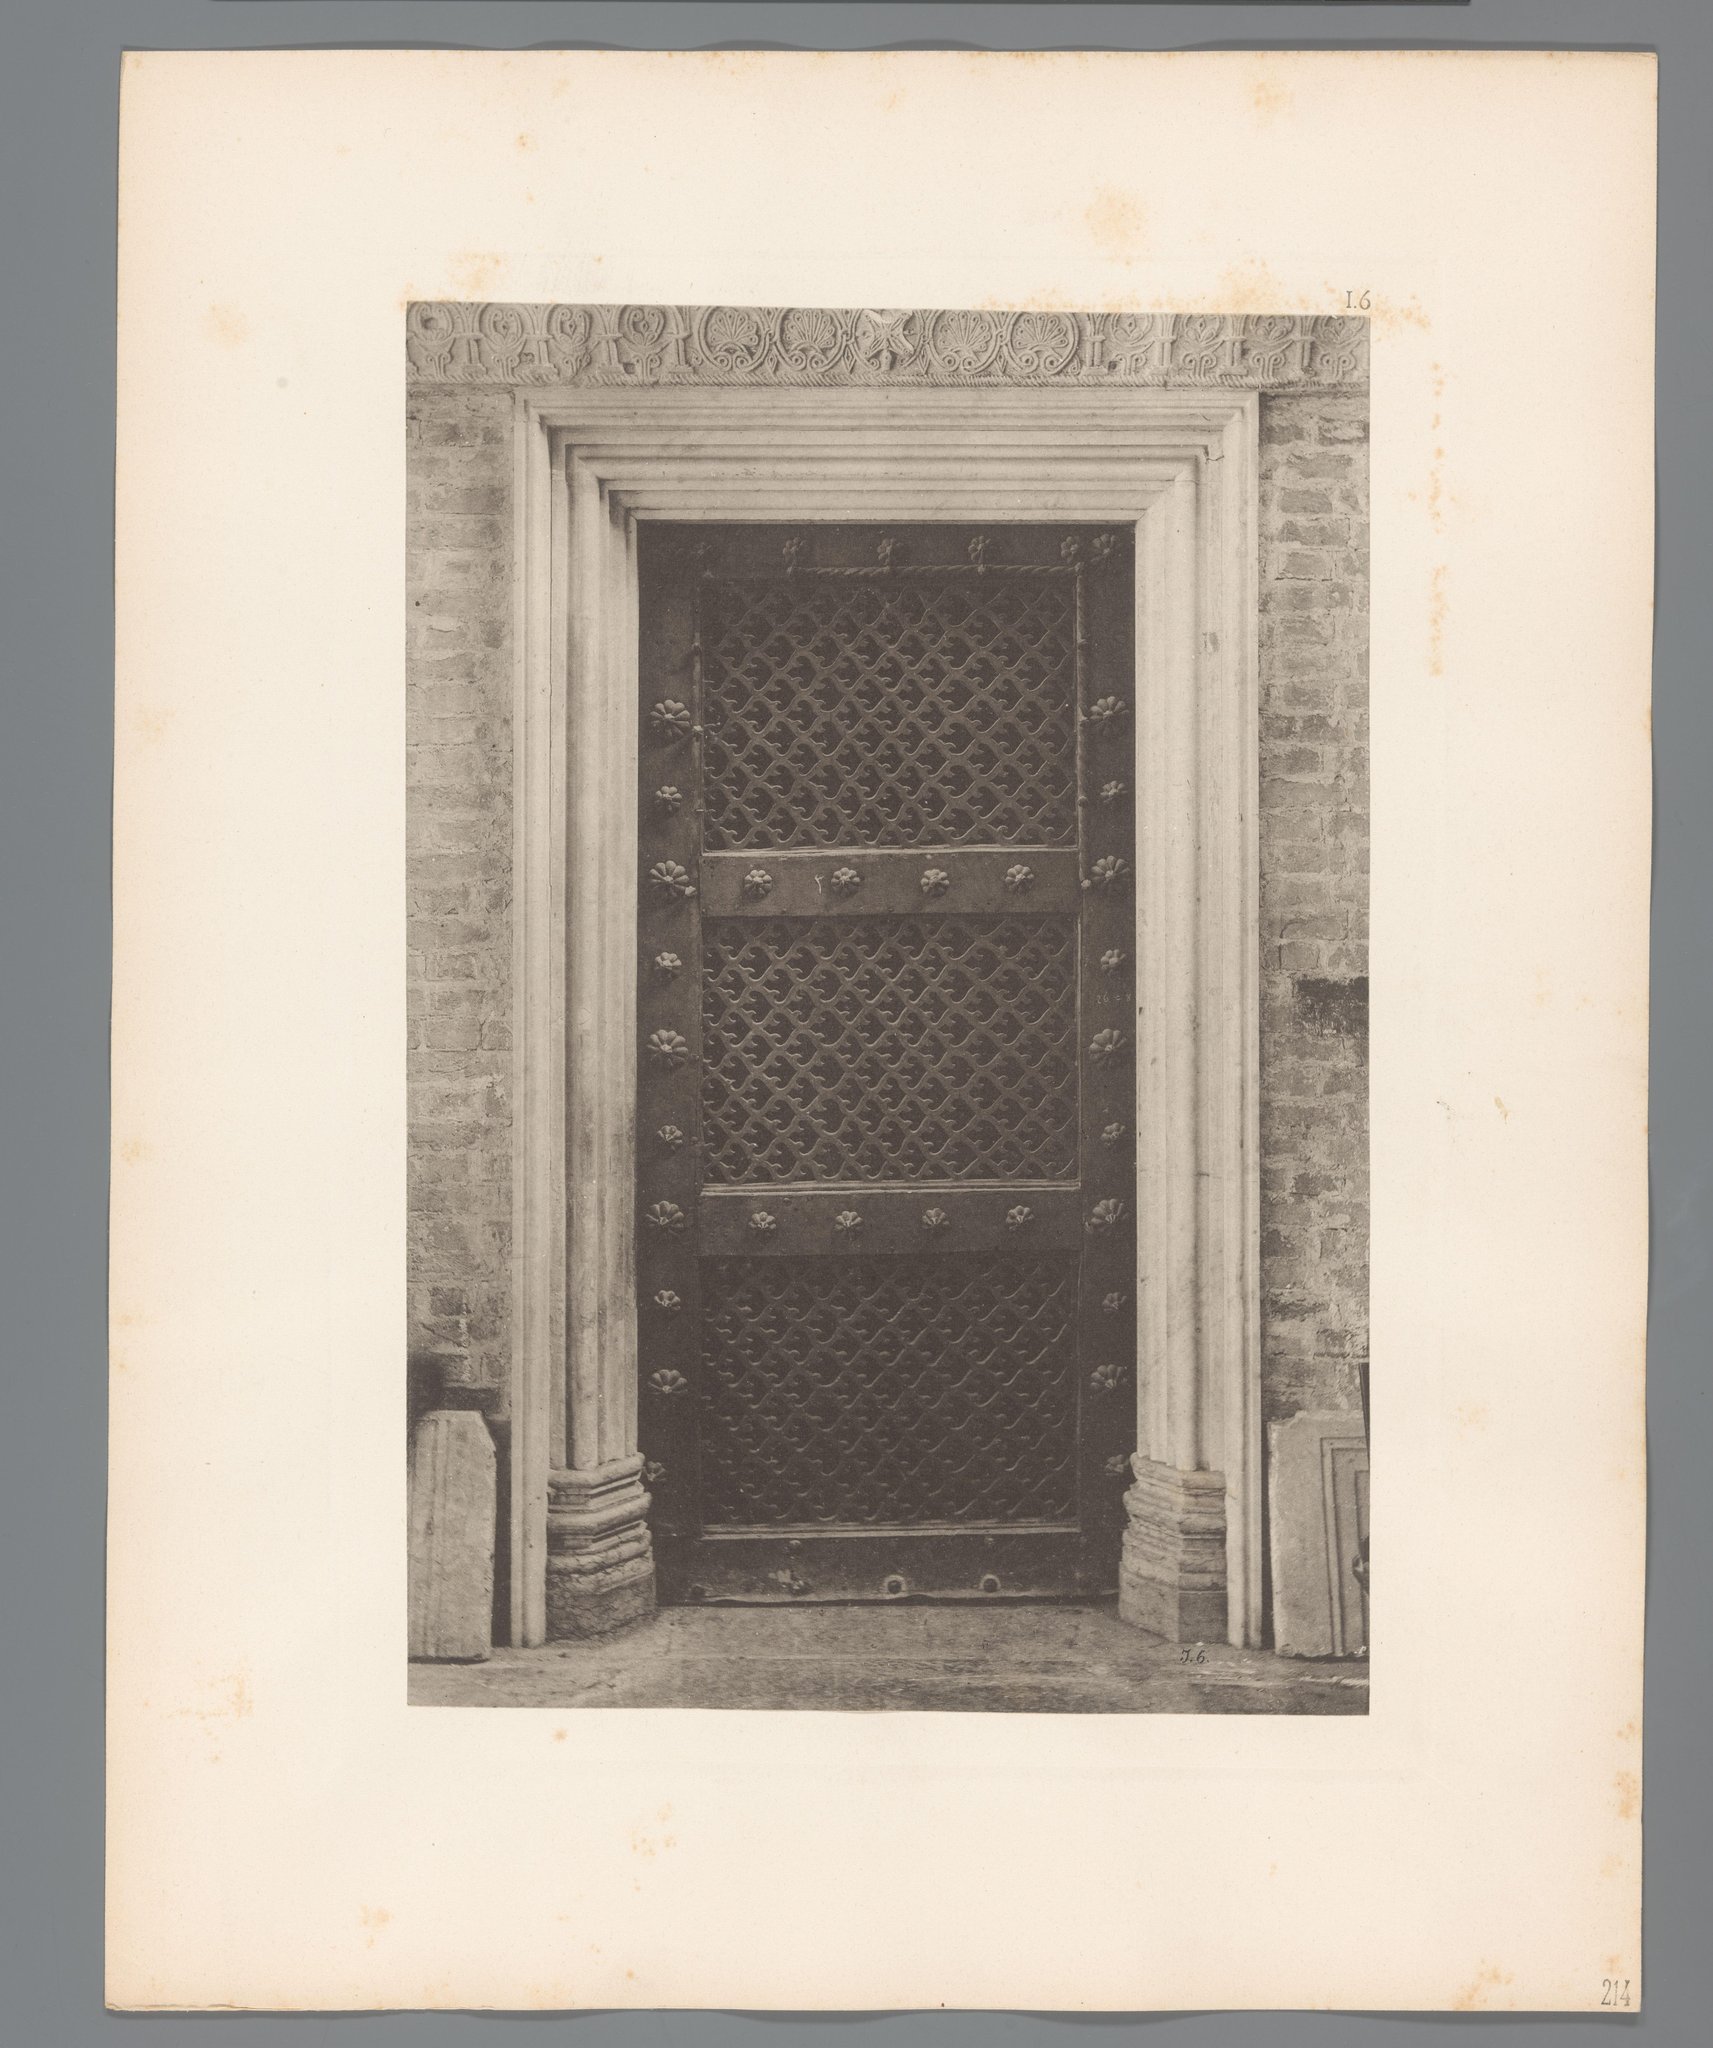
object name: photomechanical print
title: Bronzen deur van de San Marco in Venetië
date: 1880-1885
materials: paper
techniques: photograph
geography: venice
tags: church (exterior), closed door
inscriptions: number: ‘J.6.’, number: ‘I.6’, number: ‘214’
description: Deze prent maakt deel uit van een omslag met 79 prenten op 53 bladen en 2 tekstbladen.